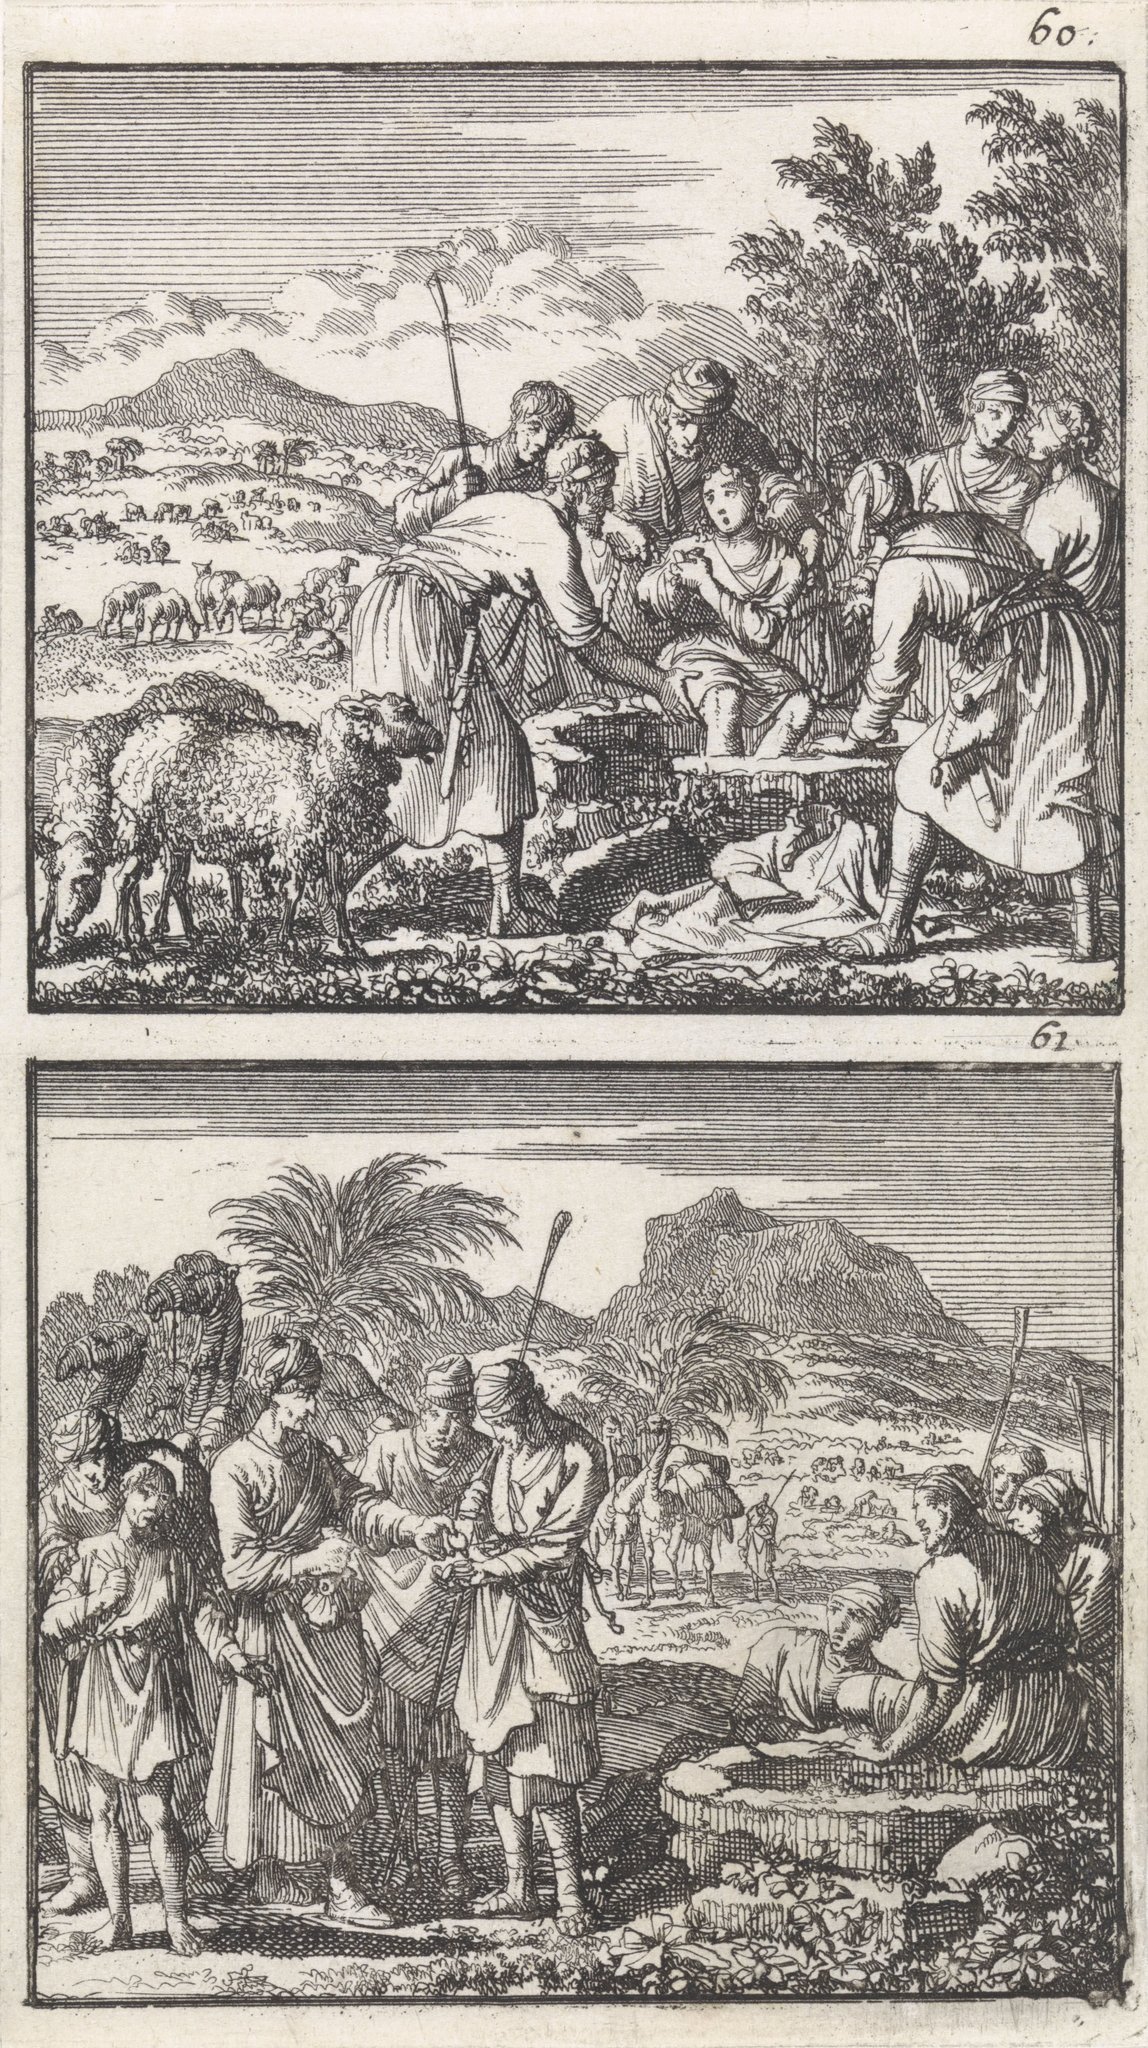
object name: book illustration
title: Jozef wordt door zijn broers in de put gegooid / Jozef door zijn broers verkocht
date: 1698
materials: paper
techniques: etching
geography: amsterdam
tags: joseph is thrown into a pit (usually depicted as a well or cistern), joseph sold into slavery and taken to egypt (genesis 37:12-35)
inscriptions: collector's mark: Lugt 2228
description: Illustraties uit: Josephus, Flavius. XX. boeken van de oude geschiedenissen der joden, 4 delen. Amsterdam: Barent Visscher, Willem de Coup, Willem van Lamsveld, Andries van Damme, 1698, dl. I.